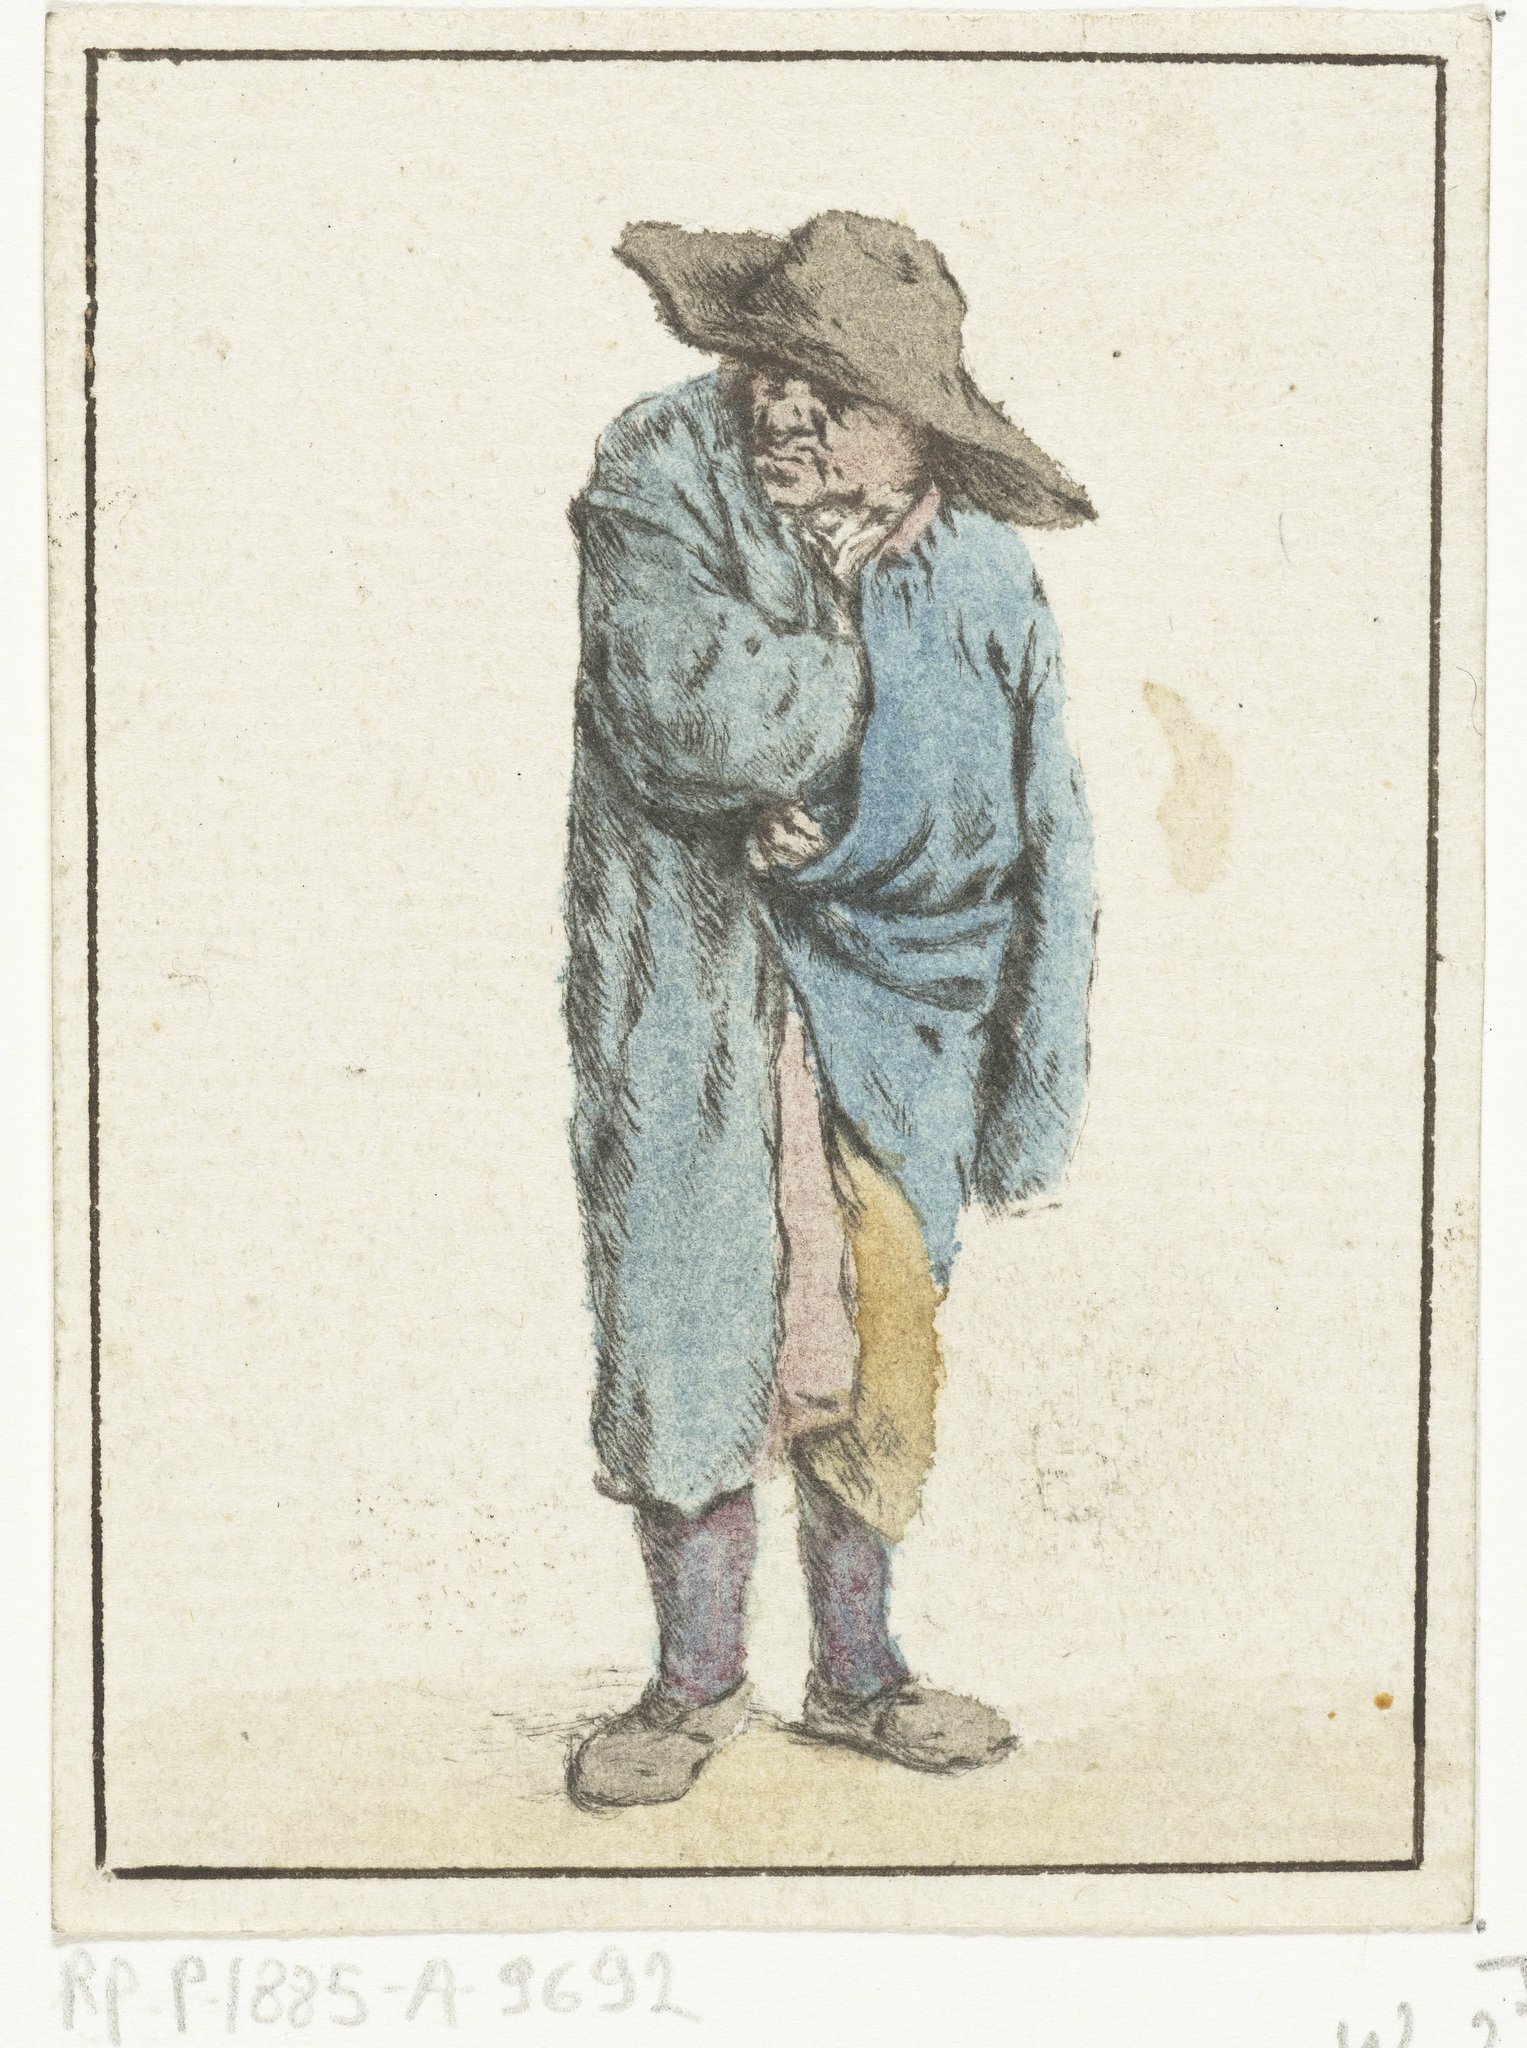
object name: print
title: Bedelaar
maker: jurriaan cootwijck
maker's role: print maker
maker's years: 1714-1798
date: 1724-1798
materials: paper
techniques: brush, printmaking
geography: haarlem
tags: farmers, beggar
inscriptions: collector's mark: Lugt 2228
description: Een man met een grote hoed, staande naar links. Zijn hand en arm in zijn mantel.